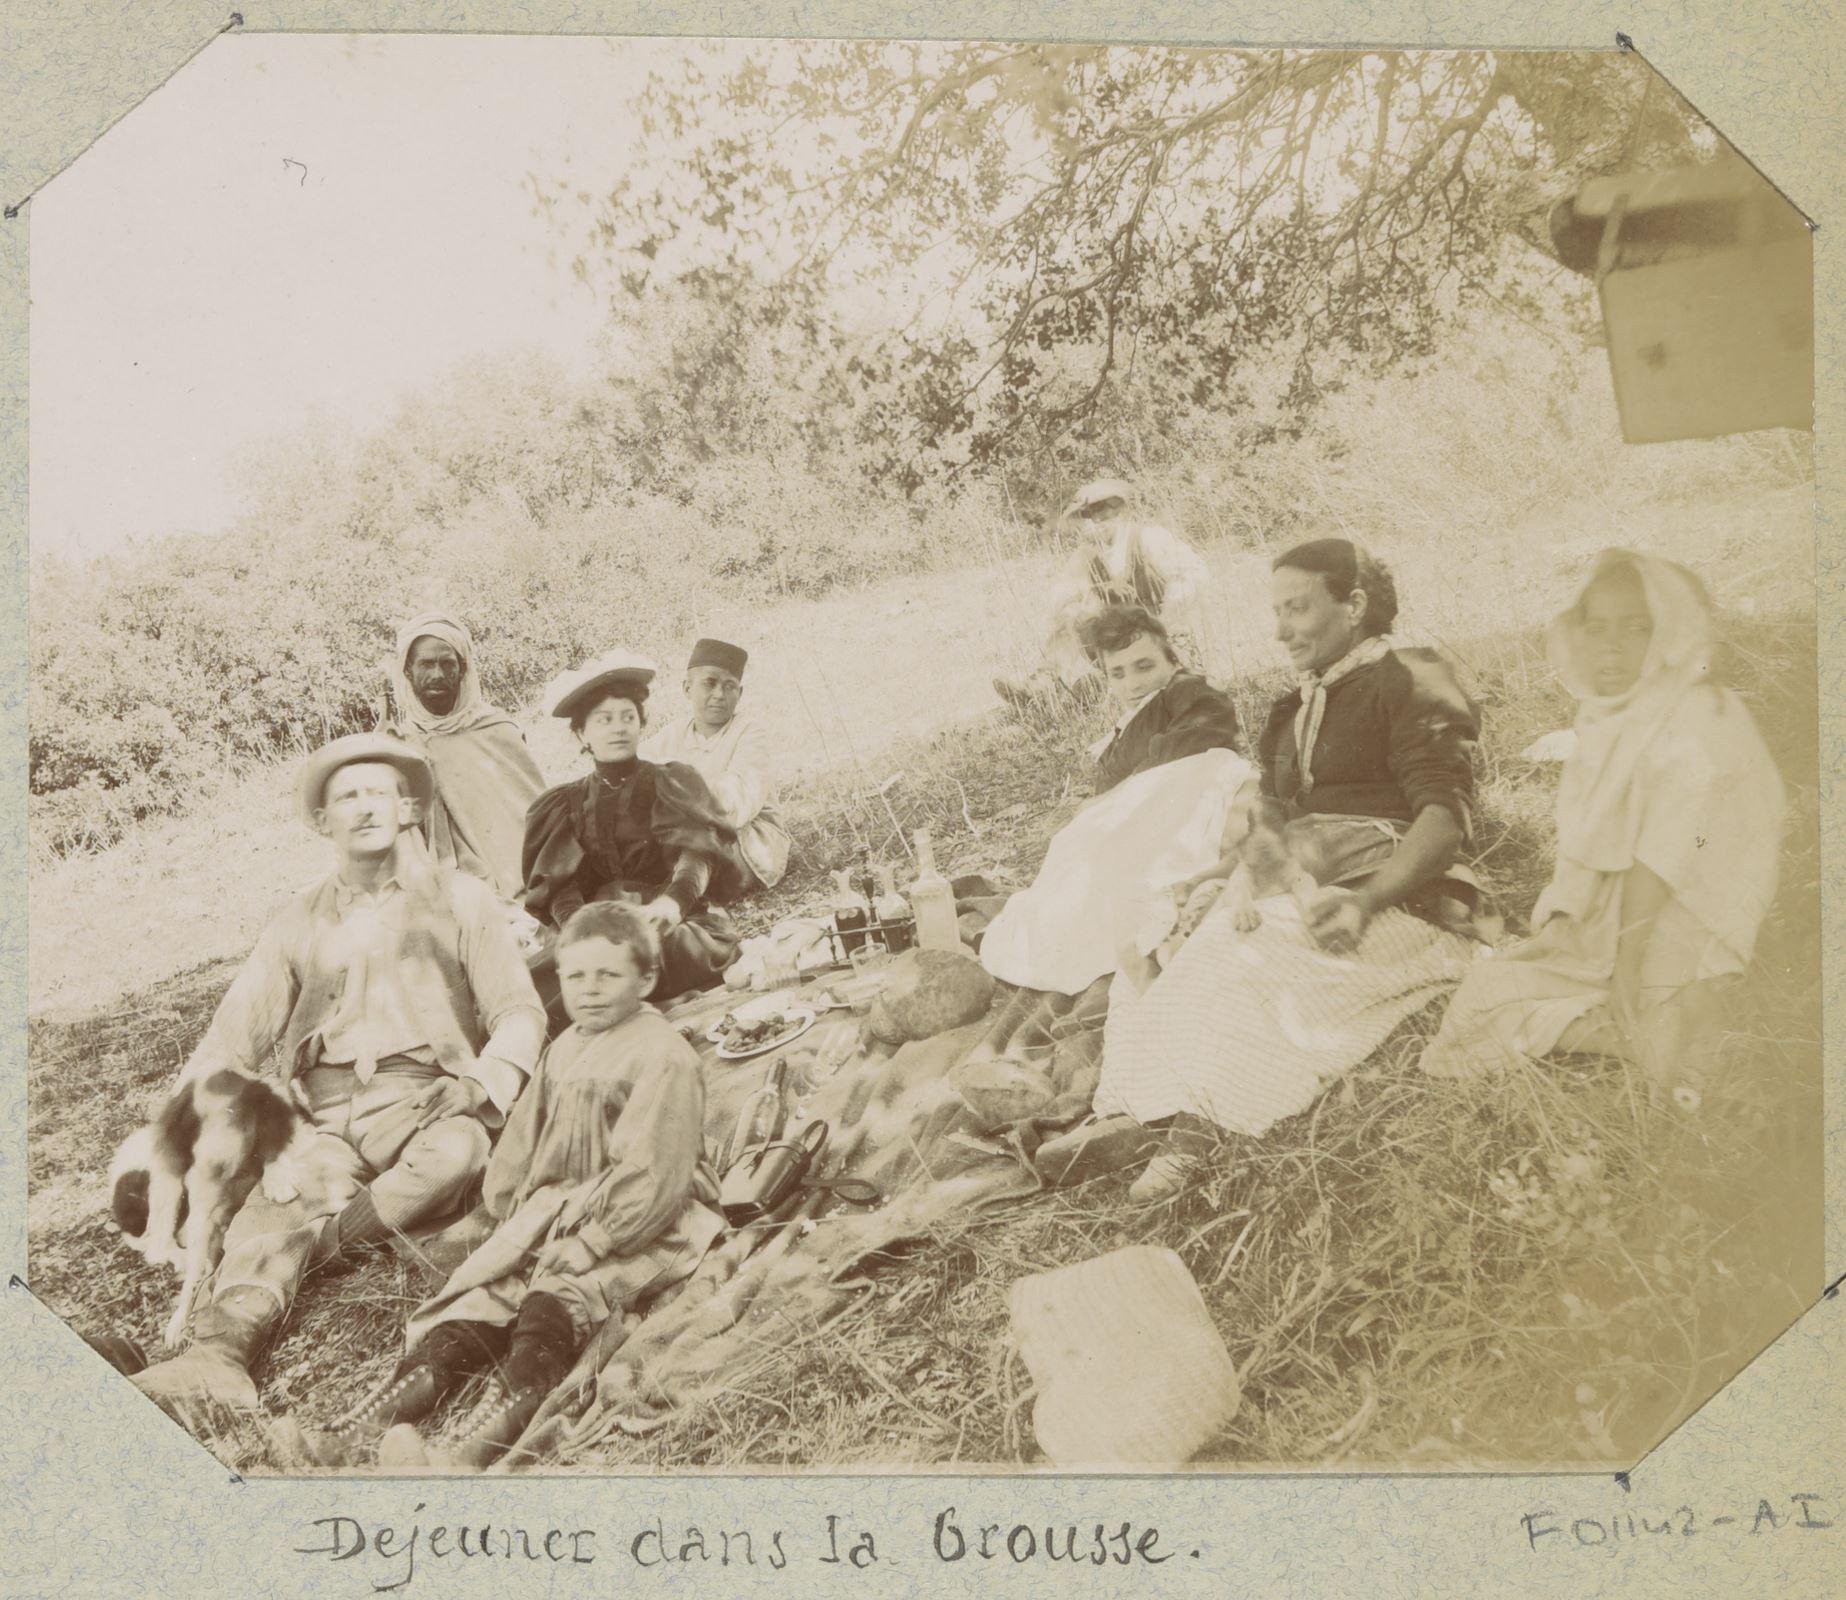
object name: album leaf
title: Mannen, vrouwen en kind aan het ontbijt in de openlucht in Algerije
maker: marotte (fotograaf)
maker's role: fotograaf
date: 1895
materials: paper, photographic support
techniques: daylight paper print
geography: algeria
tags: breakfast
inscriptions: inscription: ‘Un dejeuner dans la brousse au 40e Kilom. route de Boghari chez le secretaire de l'Etat Civil 8 k. de Berrouaghia le 7 avril 1895 Marotte’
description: Onderdeel van Album van een Franse amateur met foto's van Frankrijk, Algerije, Palmyra, de Wereldtentoonstelling van 1900 en van bekende Fransen.